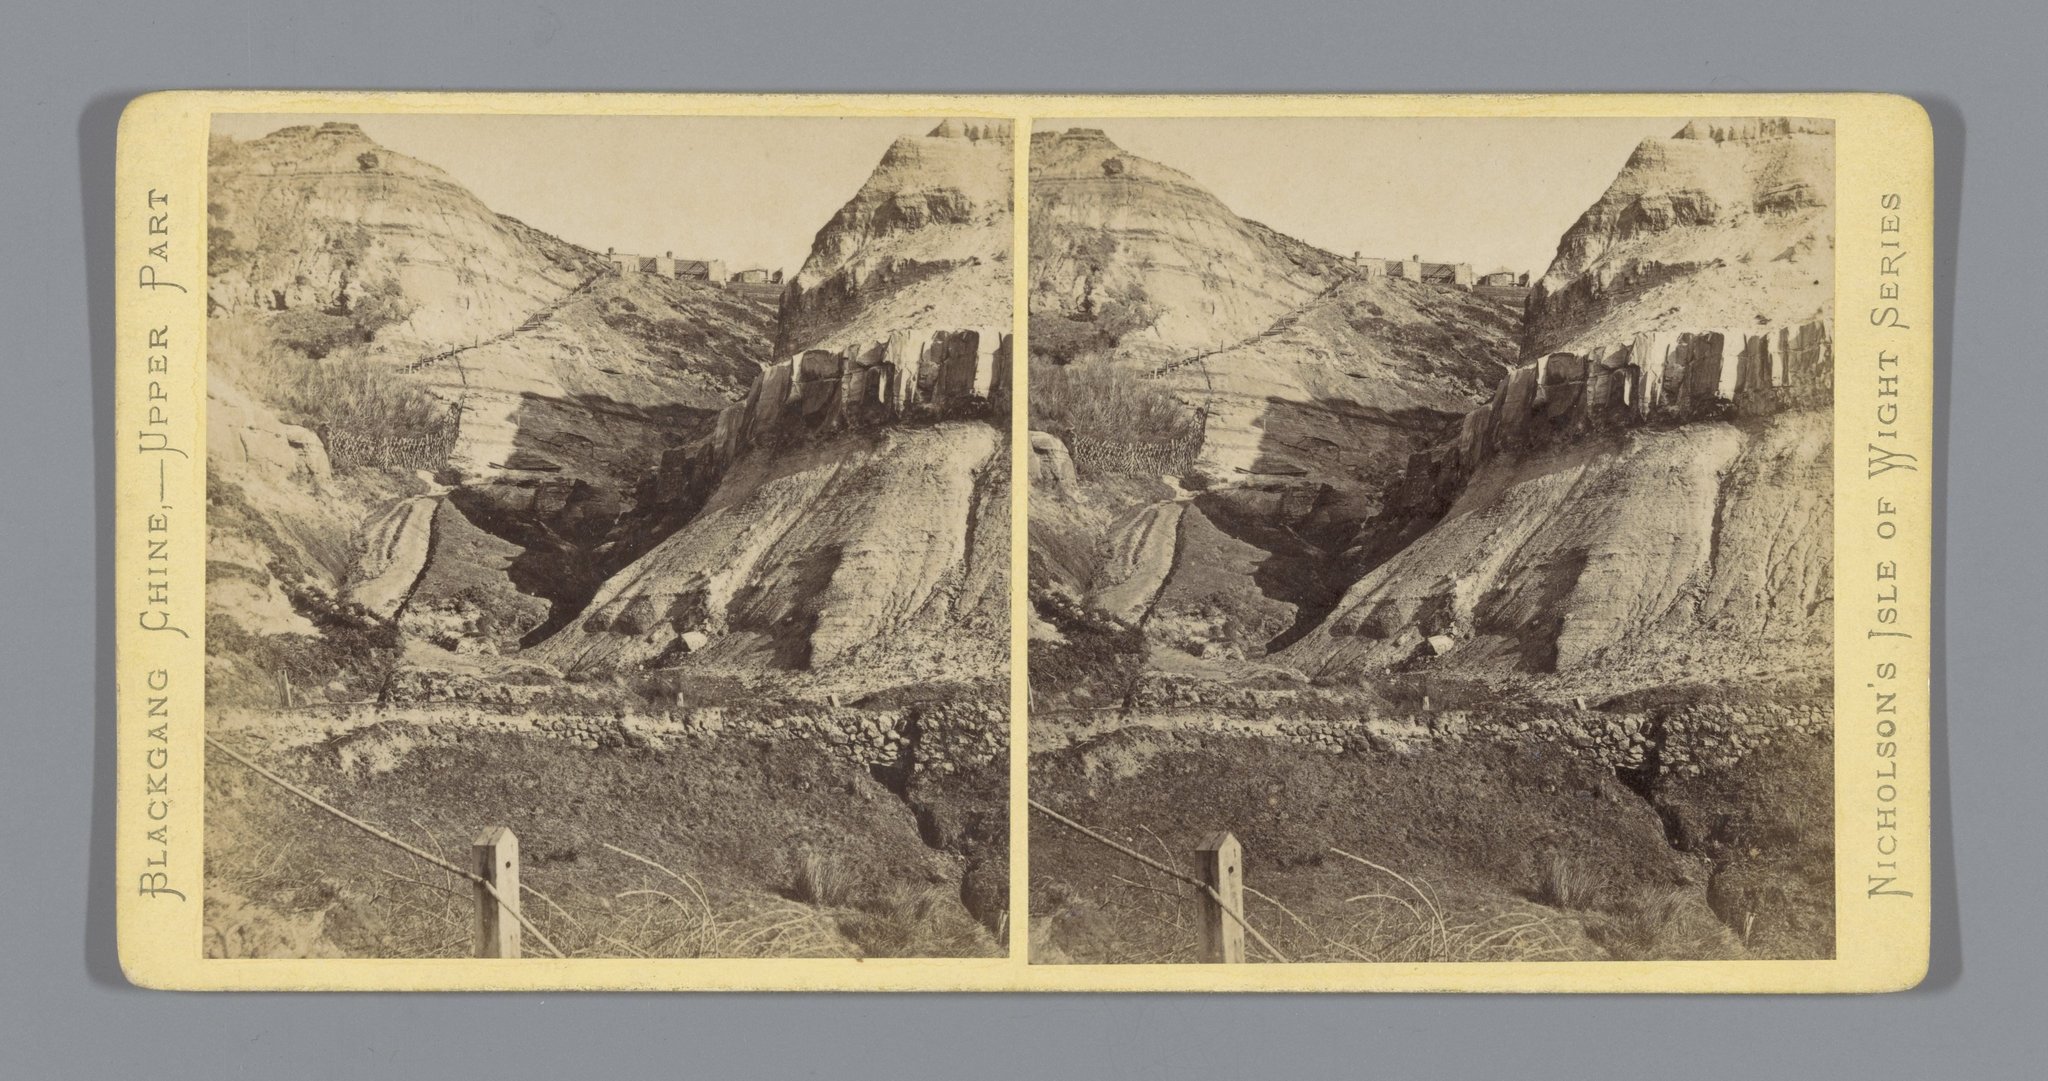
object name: stereograph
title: Gezicht op de kloof bij Blackgang Chine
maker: j.w. nicholson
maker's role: fotograaf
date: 1850-1880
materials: cardboard, photographic support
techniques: albumen print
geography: blackgang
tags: ravine, chasm, abyss, canyon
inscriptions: inscription: ‘Nicholson's Isle of Wight Series’